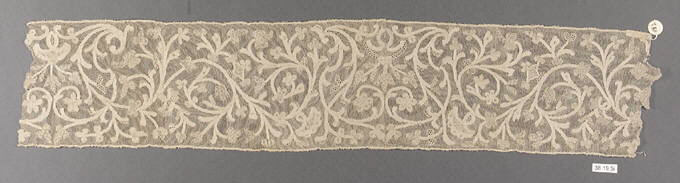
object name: hebrew ritual lace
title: Hebrew ritual lace (one of four)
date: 1701-1733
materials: silk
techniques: lace